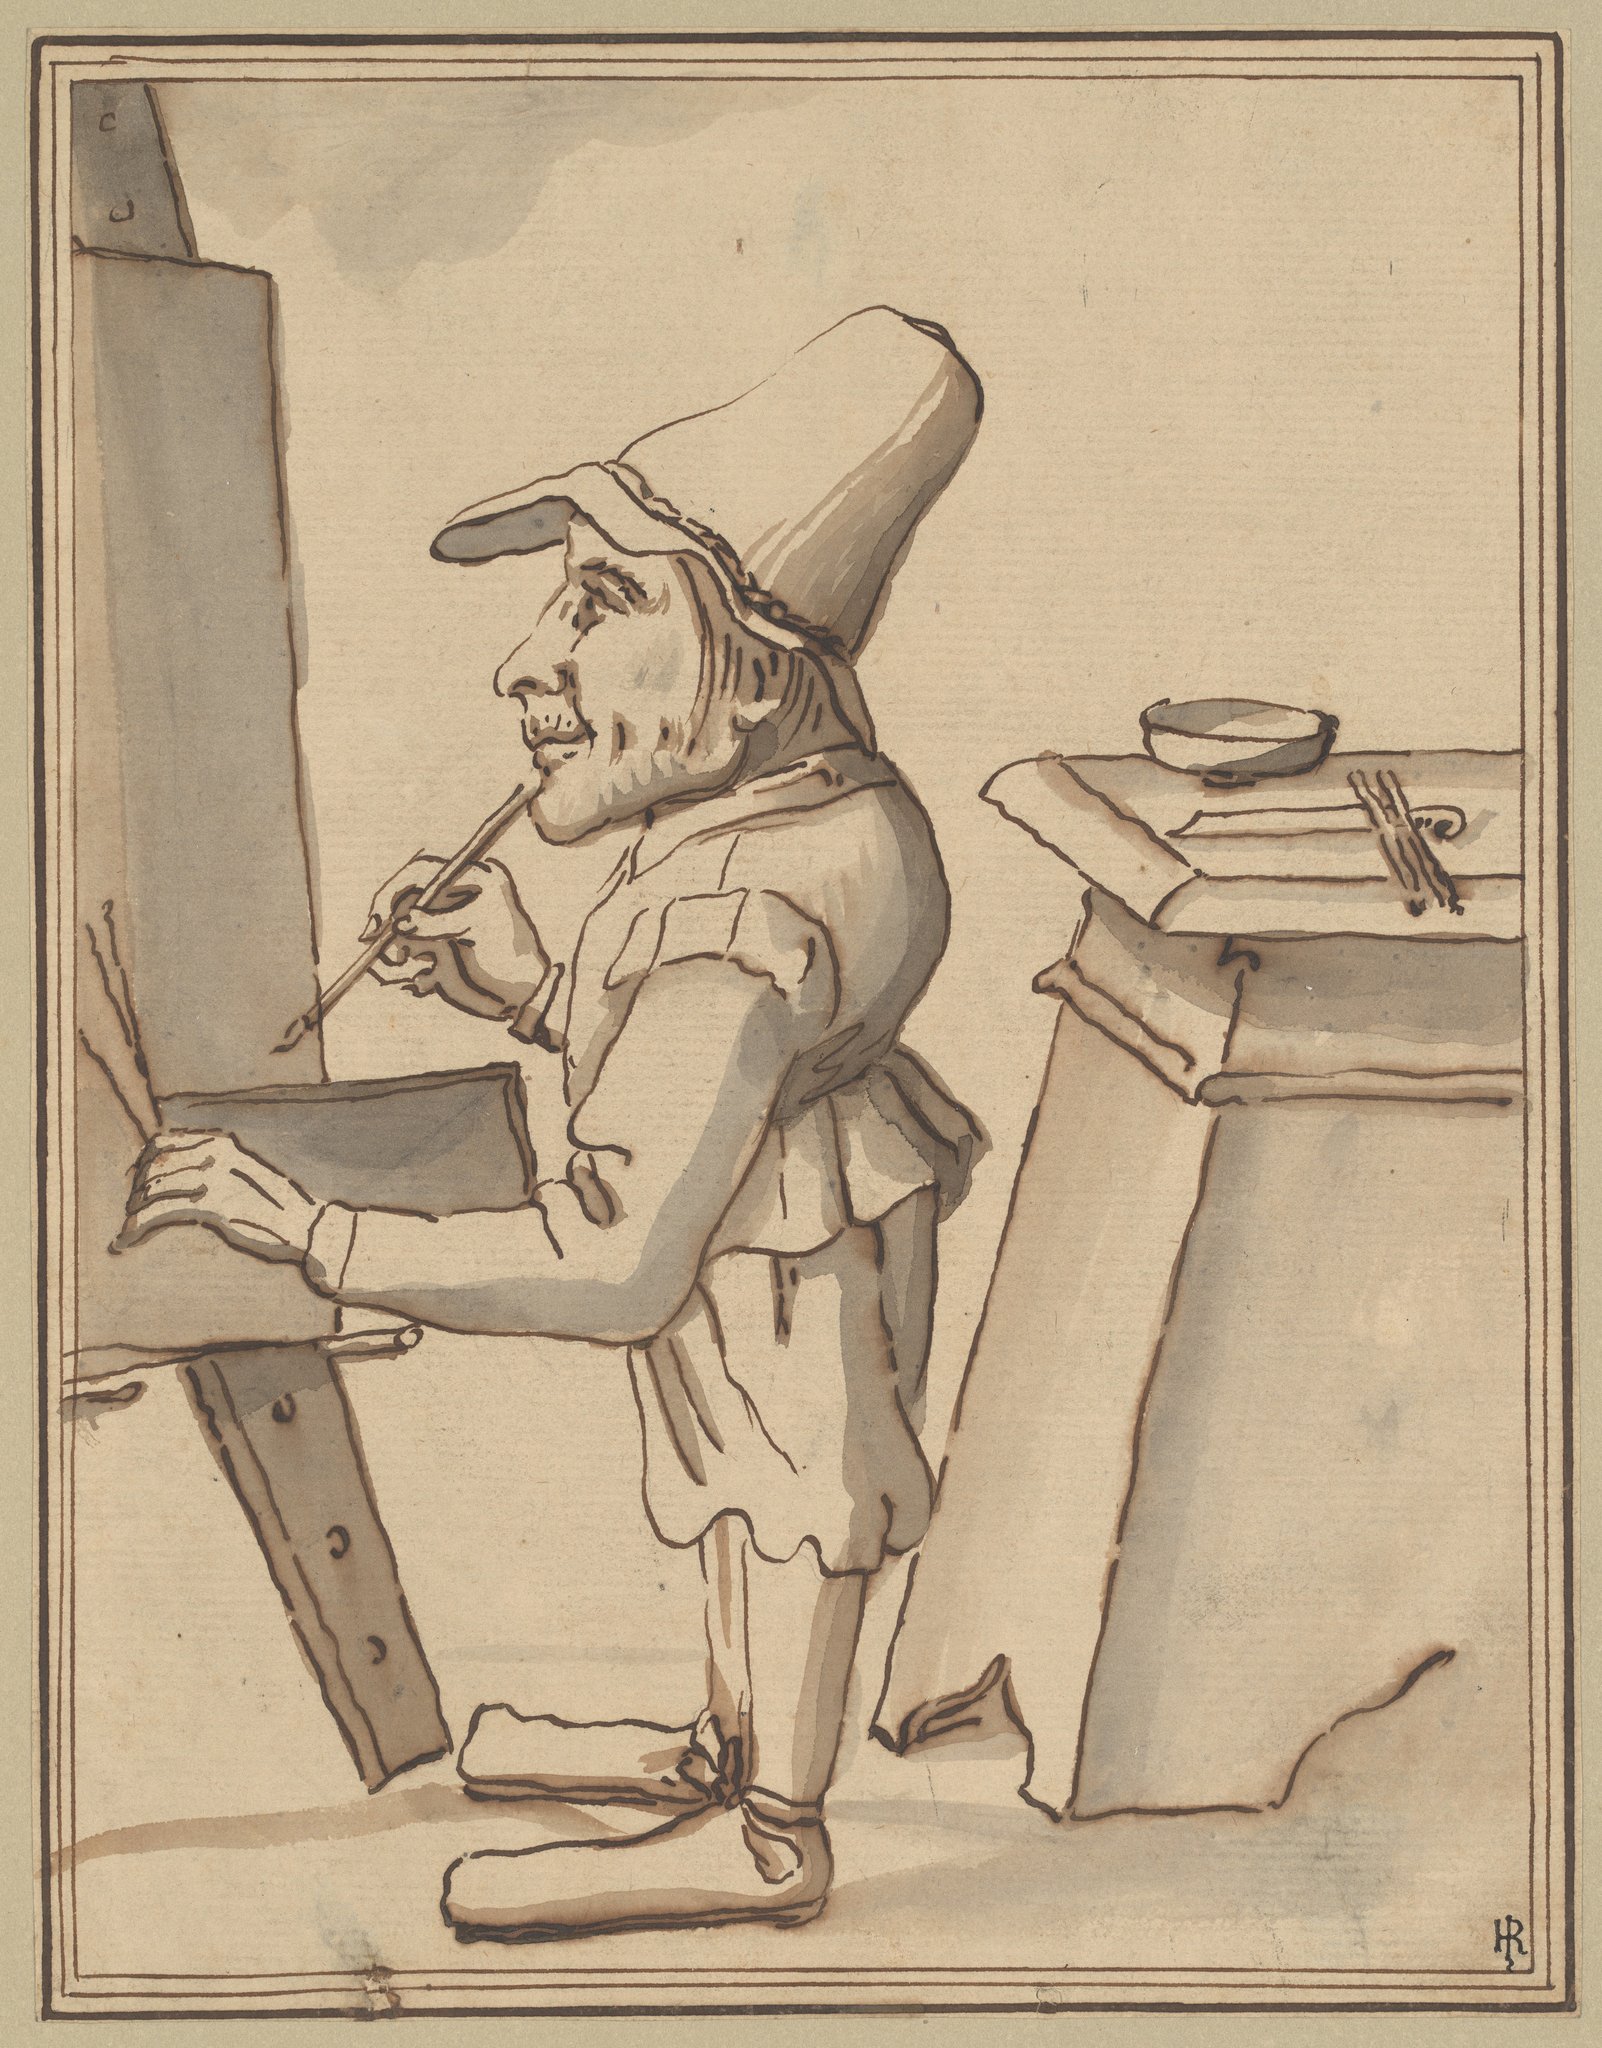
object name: drawing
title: Caricature of a Dwarf Painter at His Easel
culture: italian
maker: tuscany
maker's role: artist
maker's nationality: tuscany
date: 1601-1633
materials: ink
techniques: pen, wash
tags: painting,men